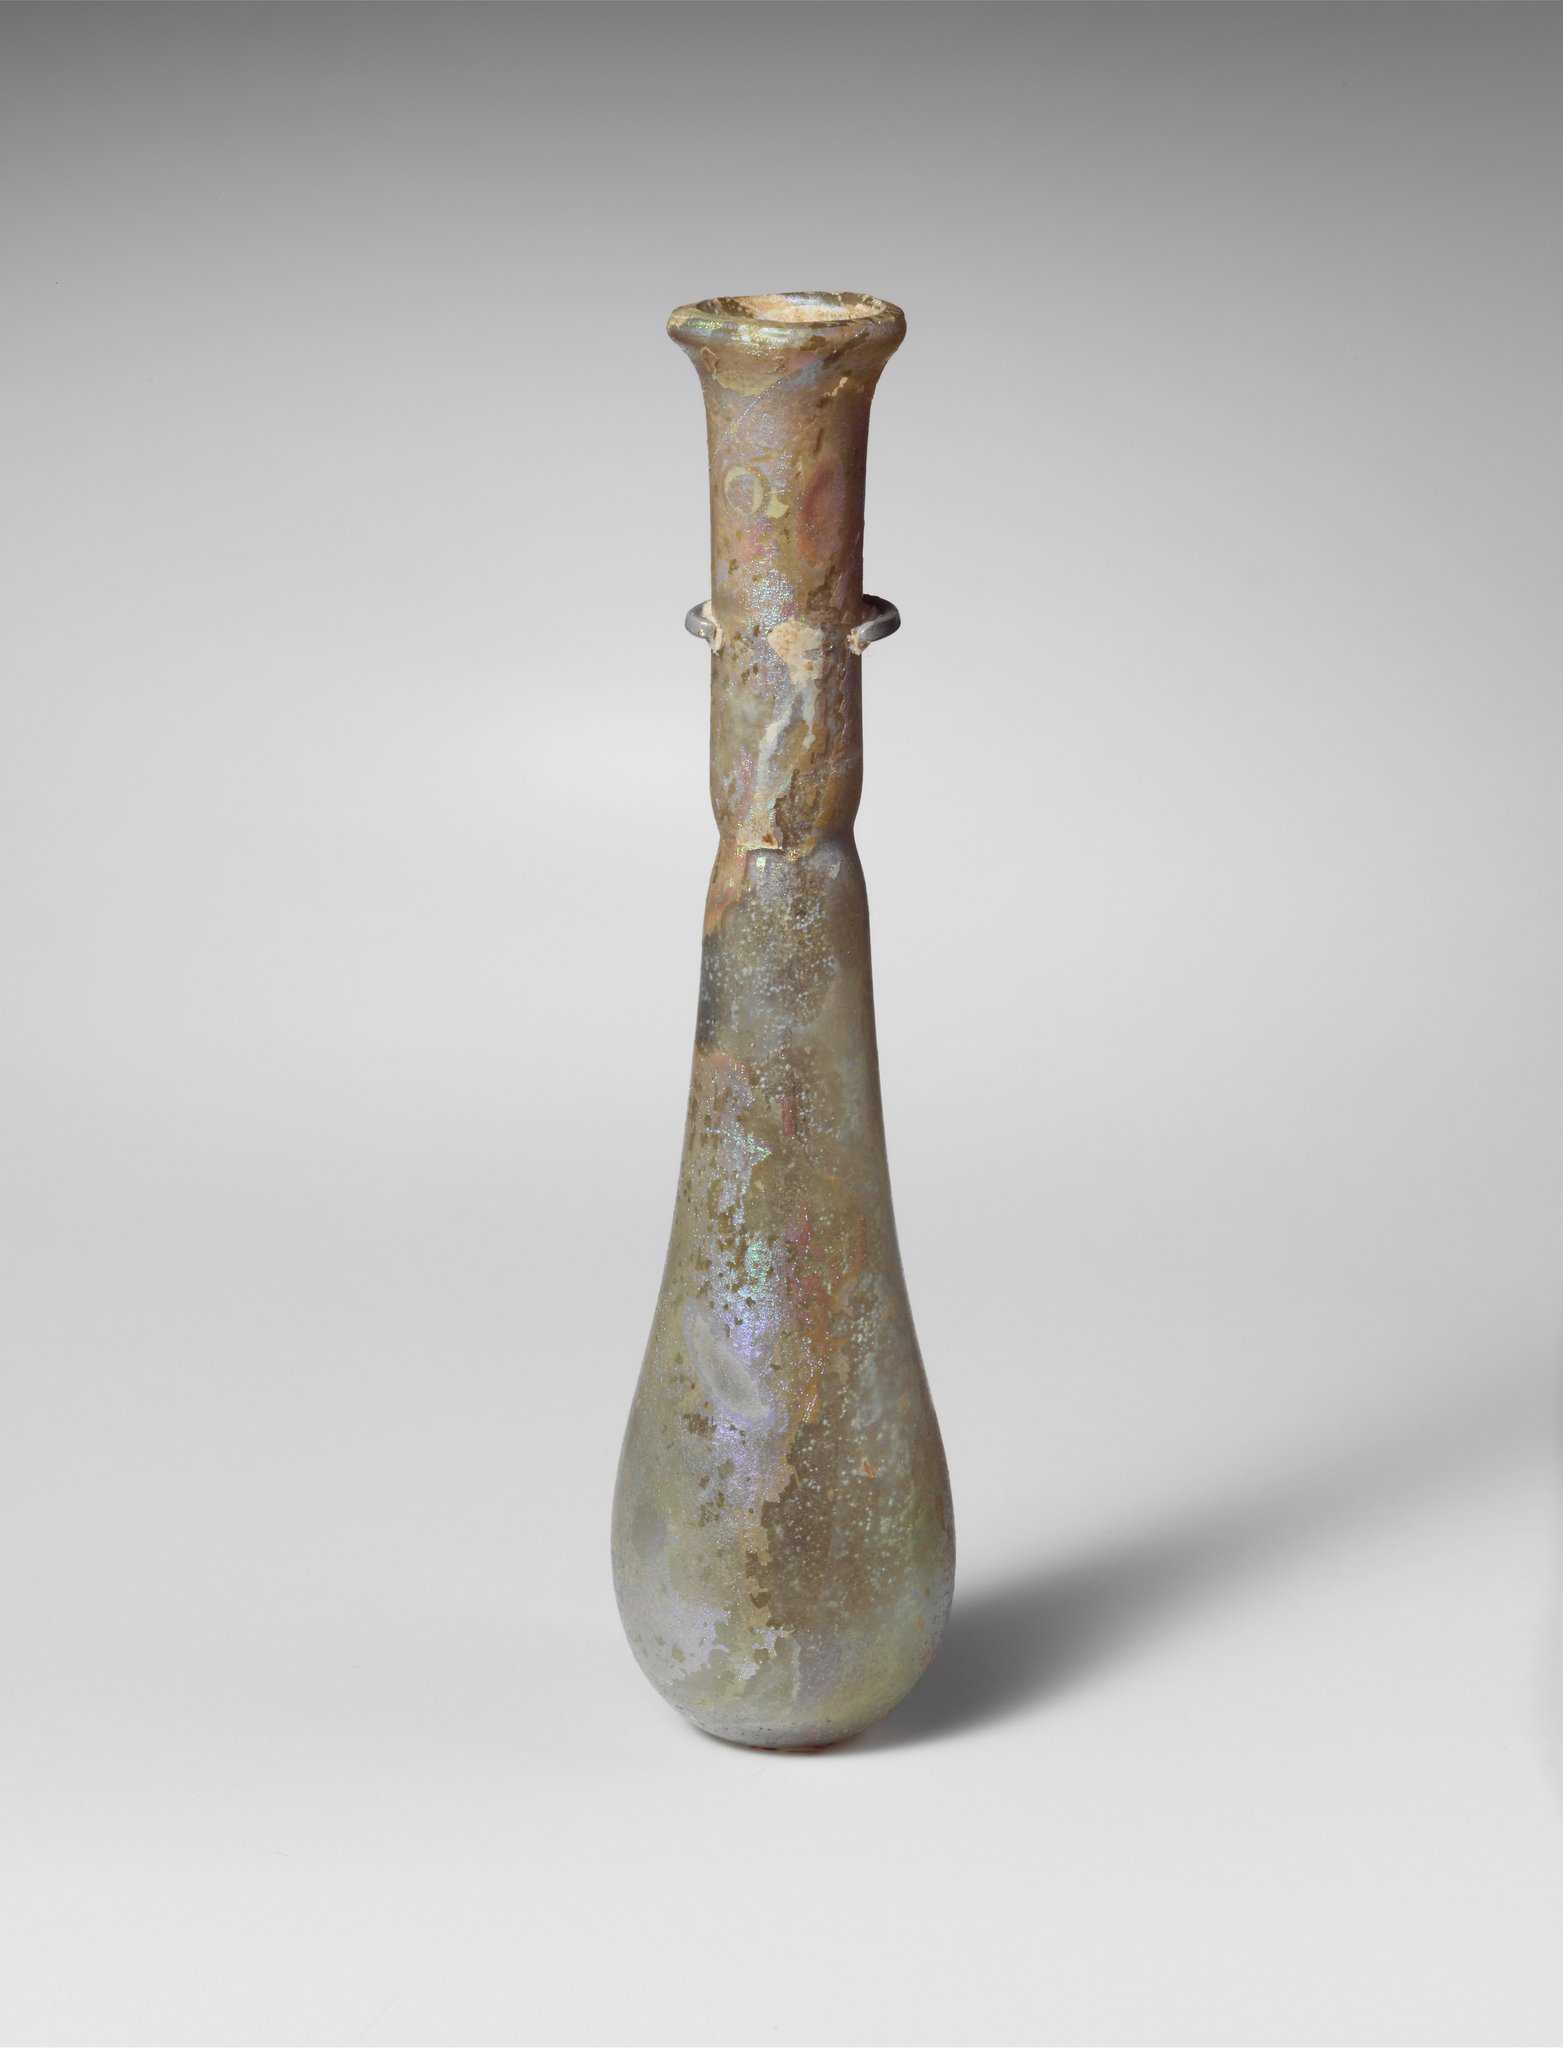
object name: perfume bottle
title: Glass perfume bottle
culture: roman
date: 1-200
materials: glass